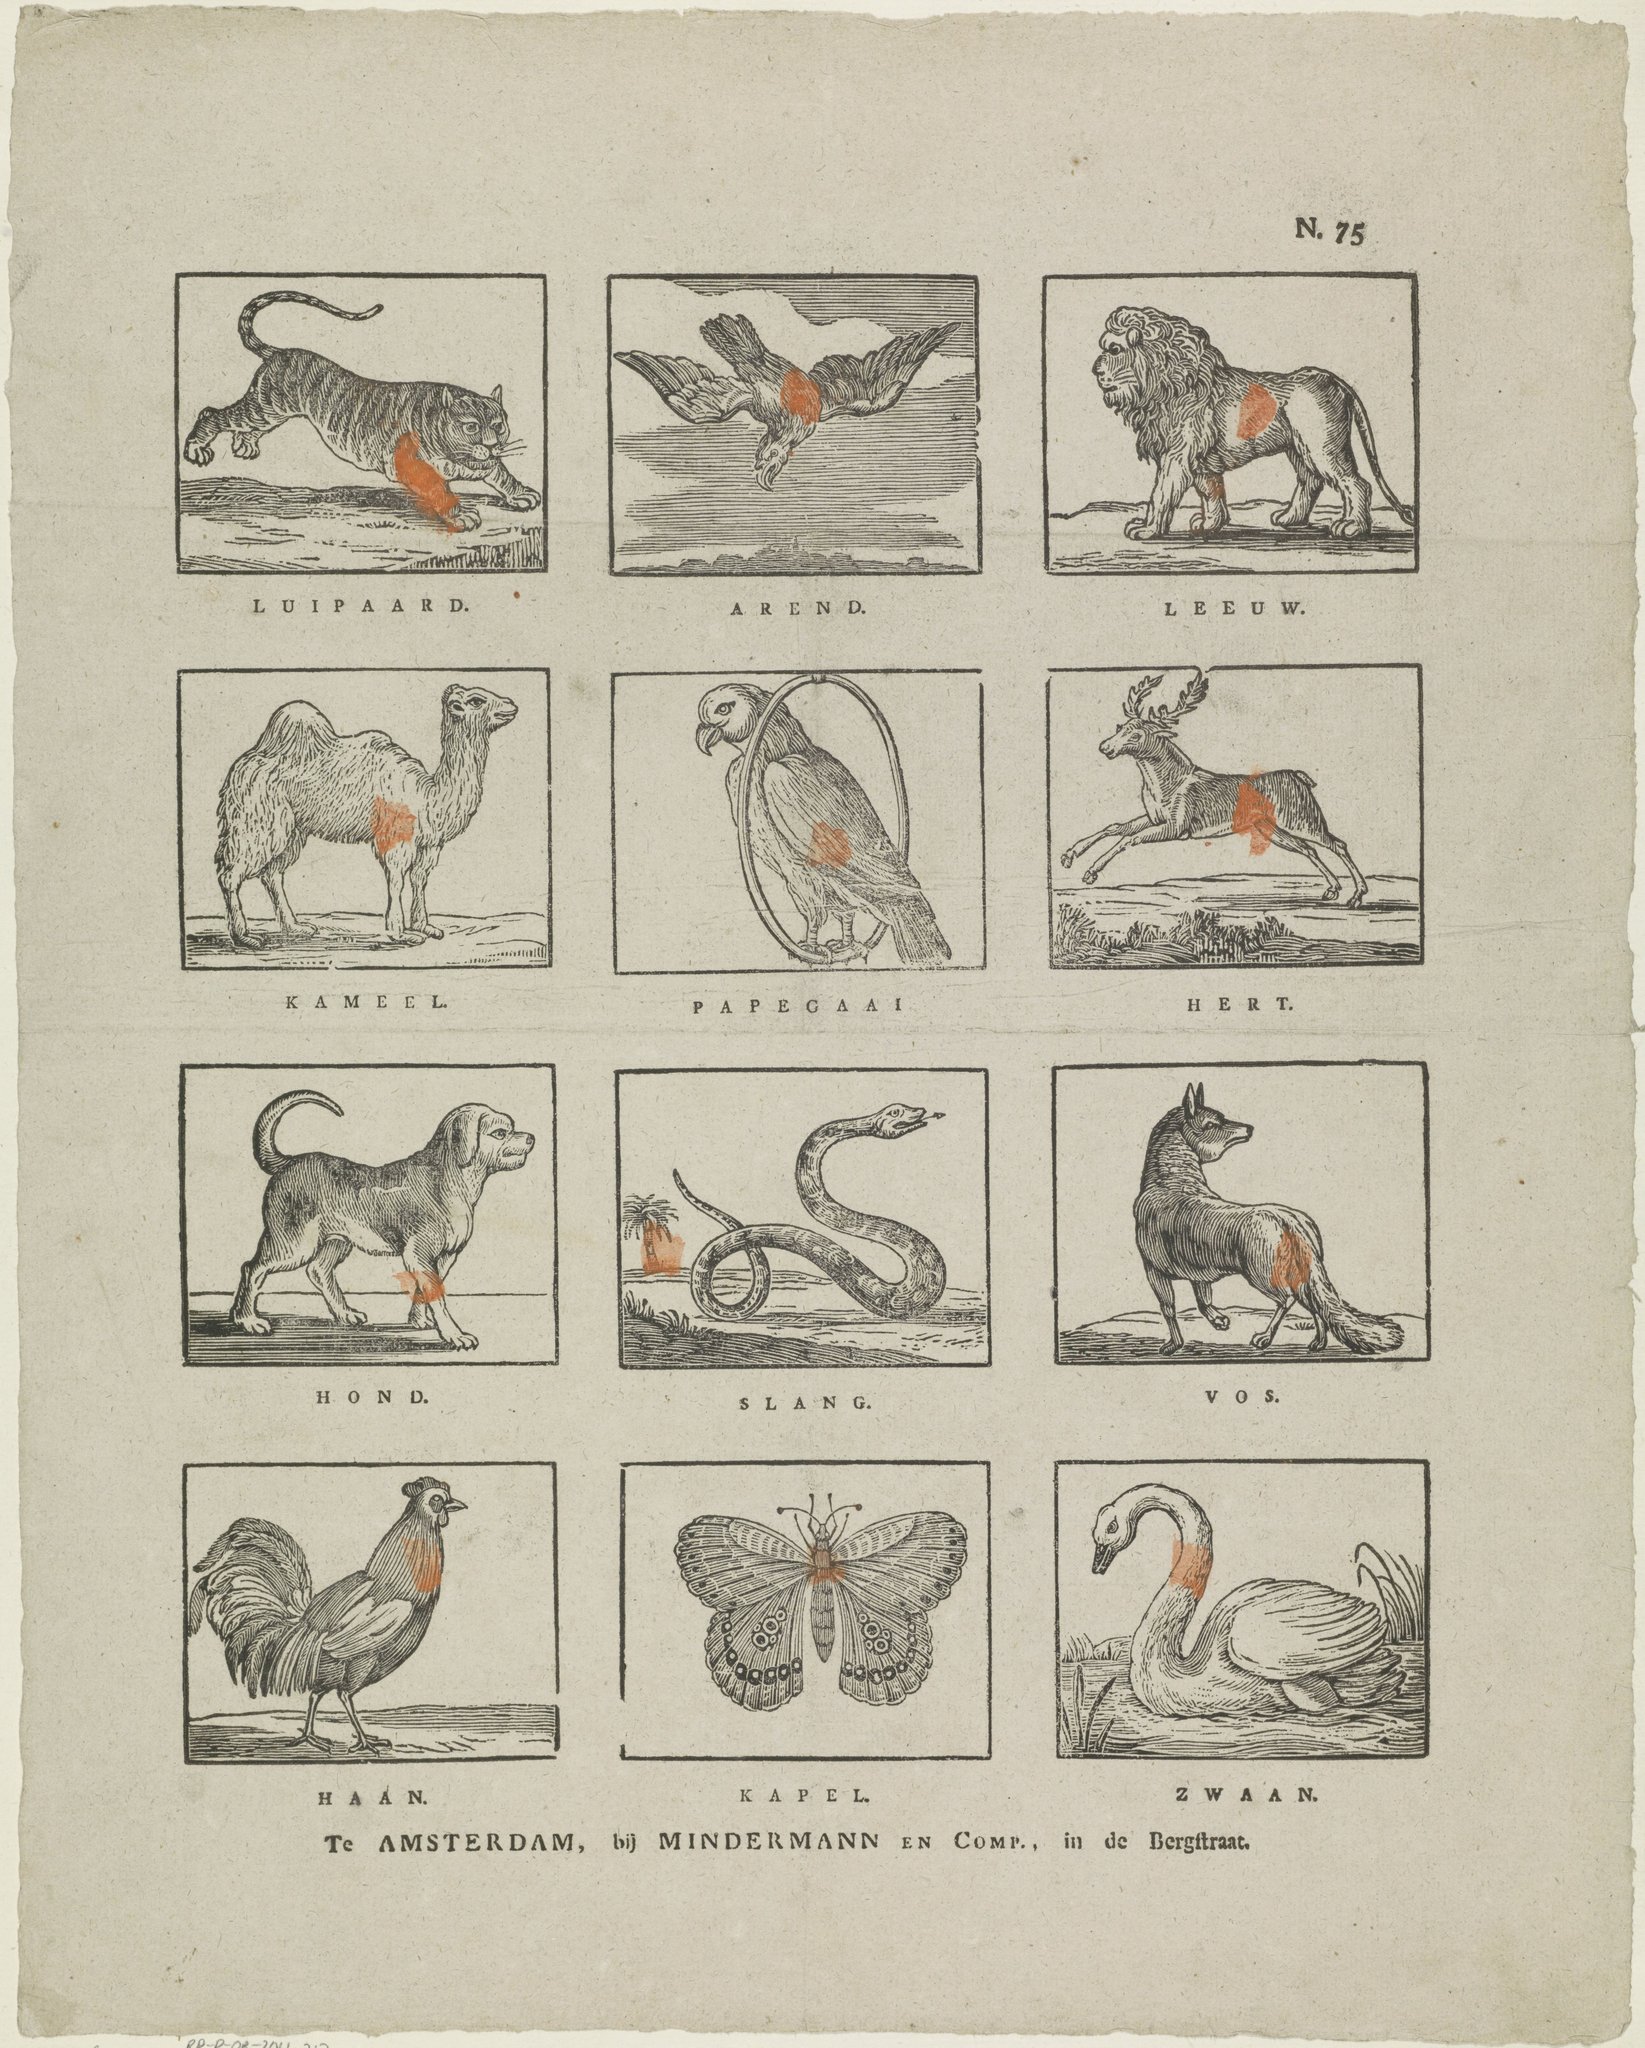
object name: popular print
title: Dieren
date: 1822-1849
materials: paper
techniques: colour, letterpress printing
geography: netherlands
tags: snakes, hoofed animals: dromedary, animals, ornamental birds: parrot, beasts of prey, predatory animals: lion, beasts of prey, predatory animals: fox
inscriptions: collector's mark: Lugt 2760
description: Blad met 12 voorstellingen van dieren, zoals een luipaard, een arend, een leeuw en een vlinder. Onder elke afbeelding een onderschrift. Genummerd rechtsboven: N. 75.